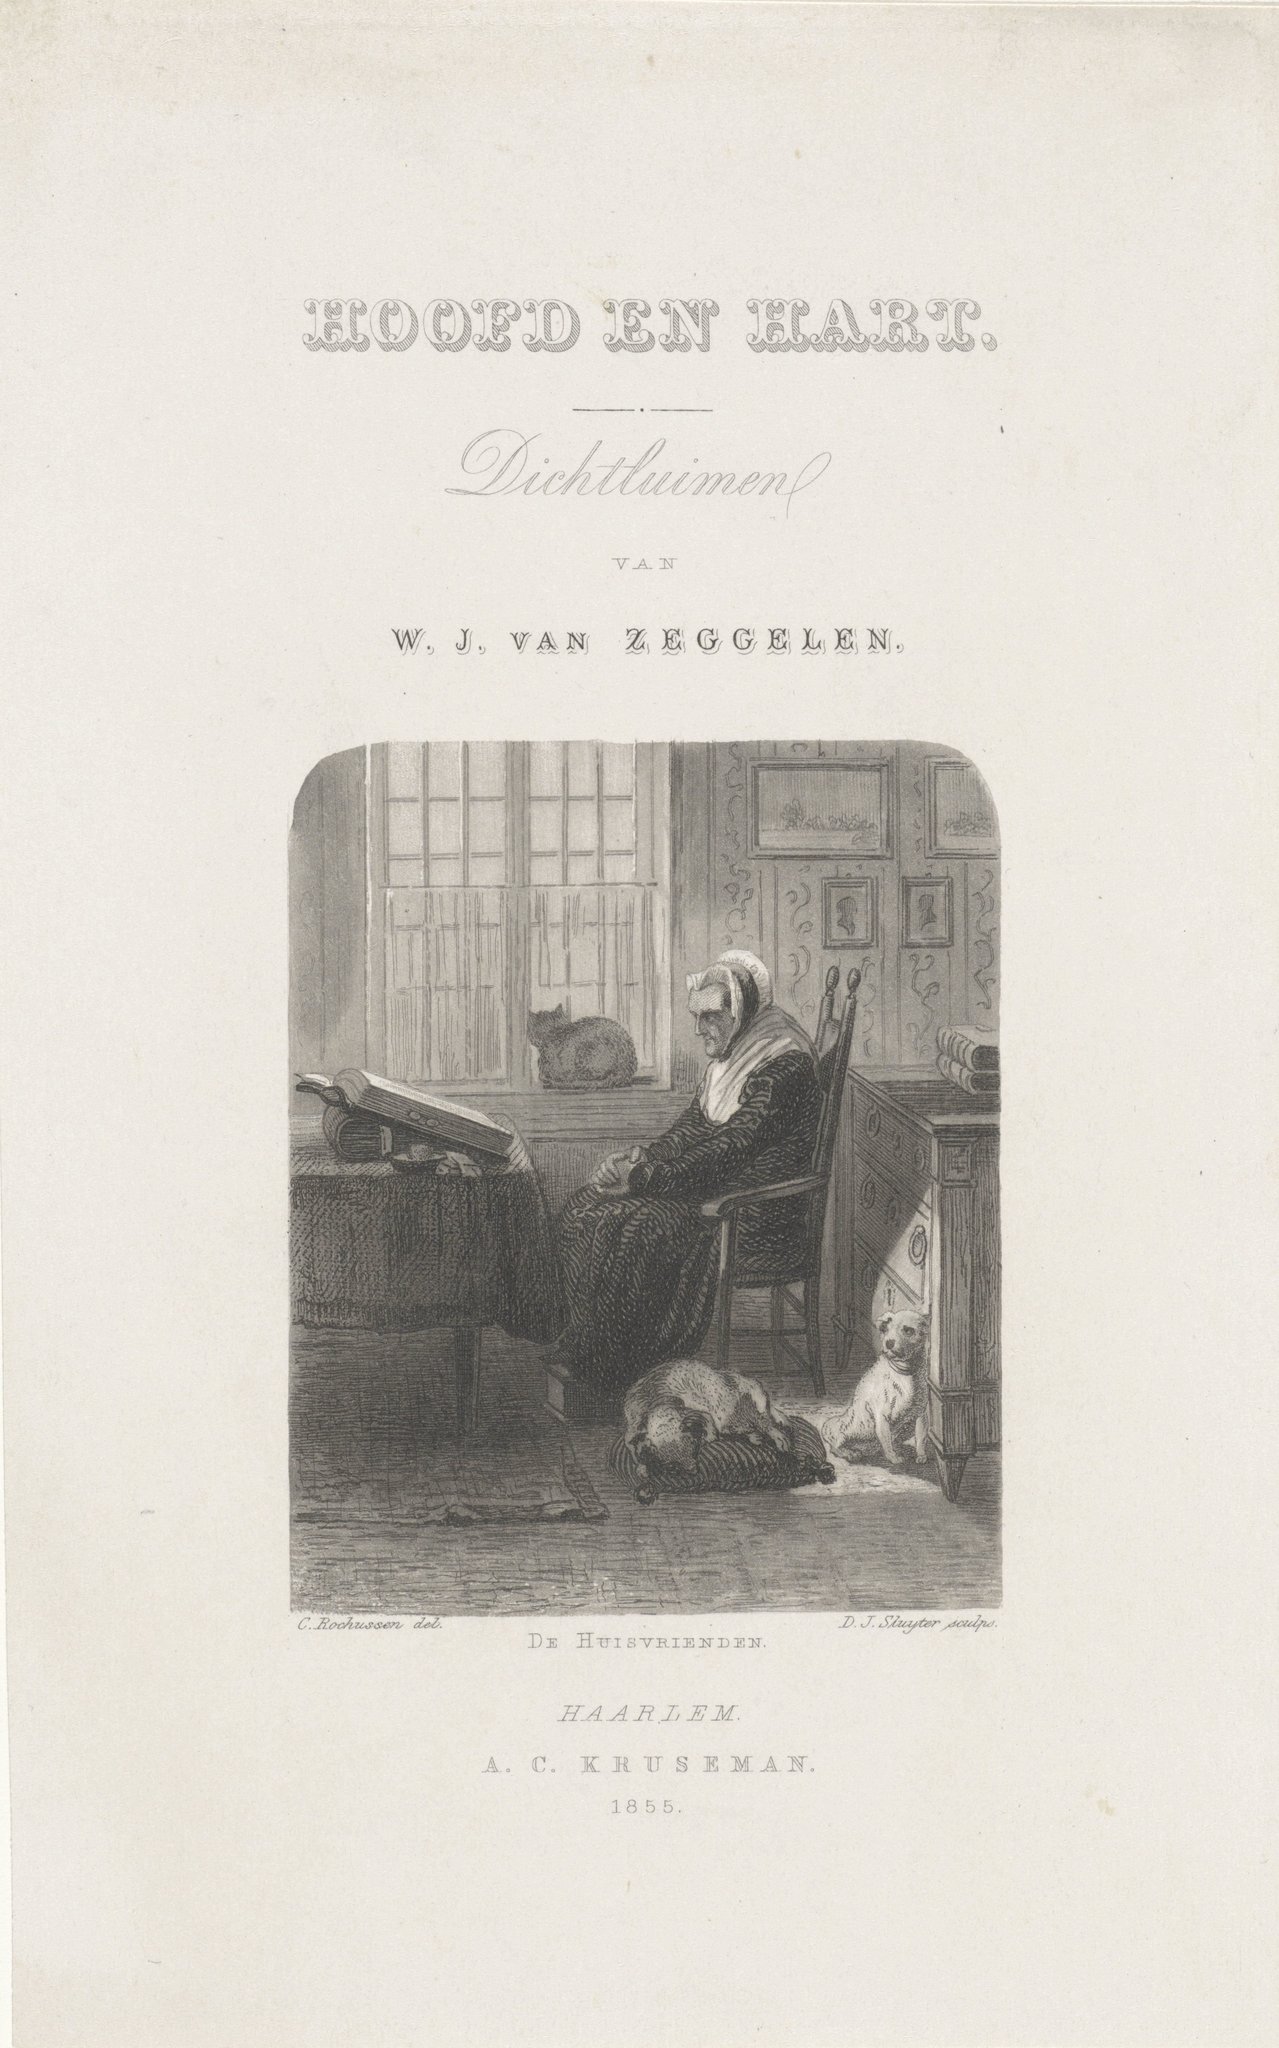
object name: titelblad, titelpagina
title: Titelpagina voor: W.J. van Zeggelen, Hoofd en hart, 1855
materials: paper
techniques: aquatint, etching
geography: haarlem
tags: cat, book - mm - book open, one person praying, dog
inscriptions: collector's mark: Lugt 2228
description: Een oude vrouw zit met gevouwen handen in een stoel. Op de tafel voor haar ligt een lijvige foliant opengeslagen, gesteund door een tweede boek. Op de grond zitten twee hondjes, voor het raam een poes.